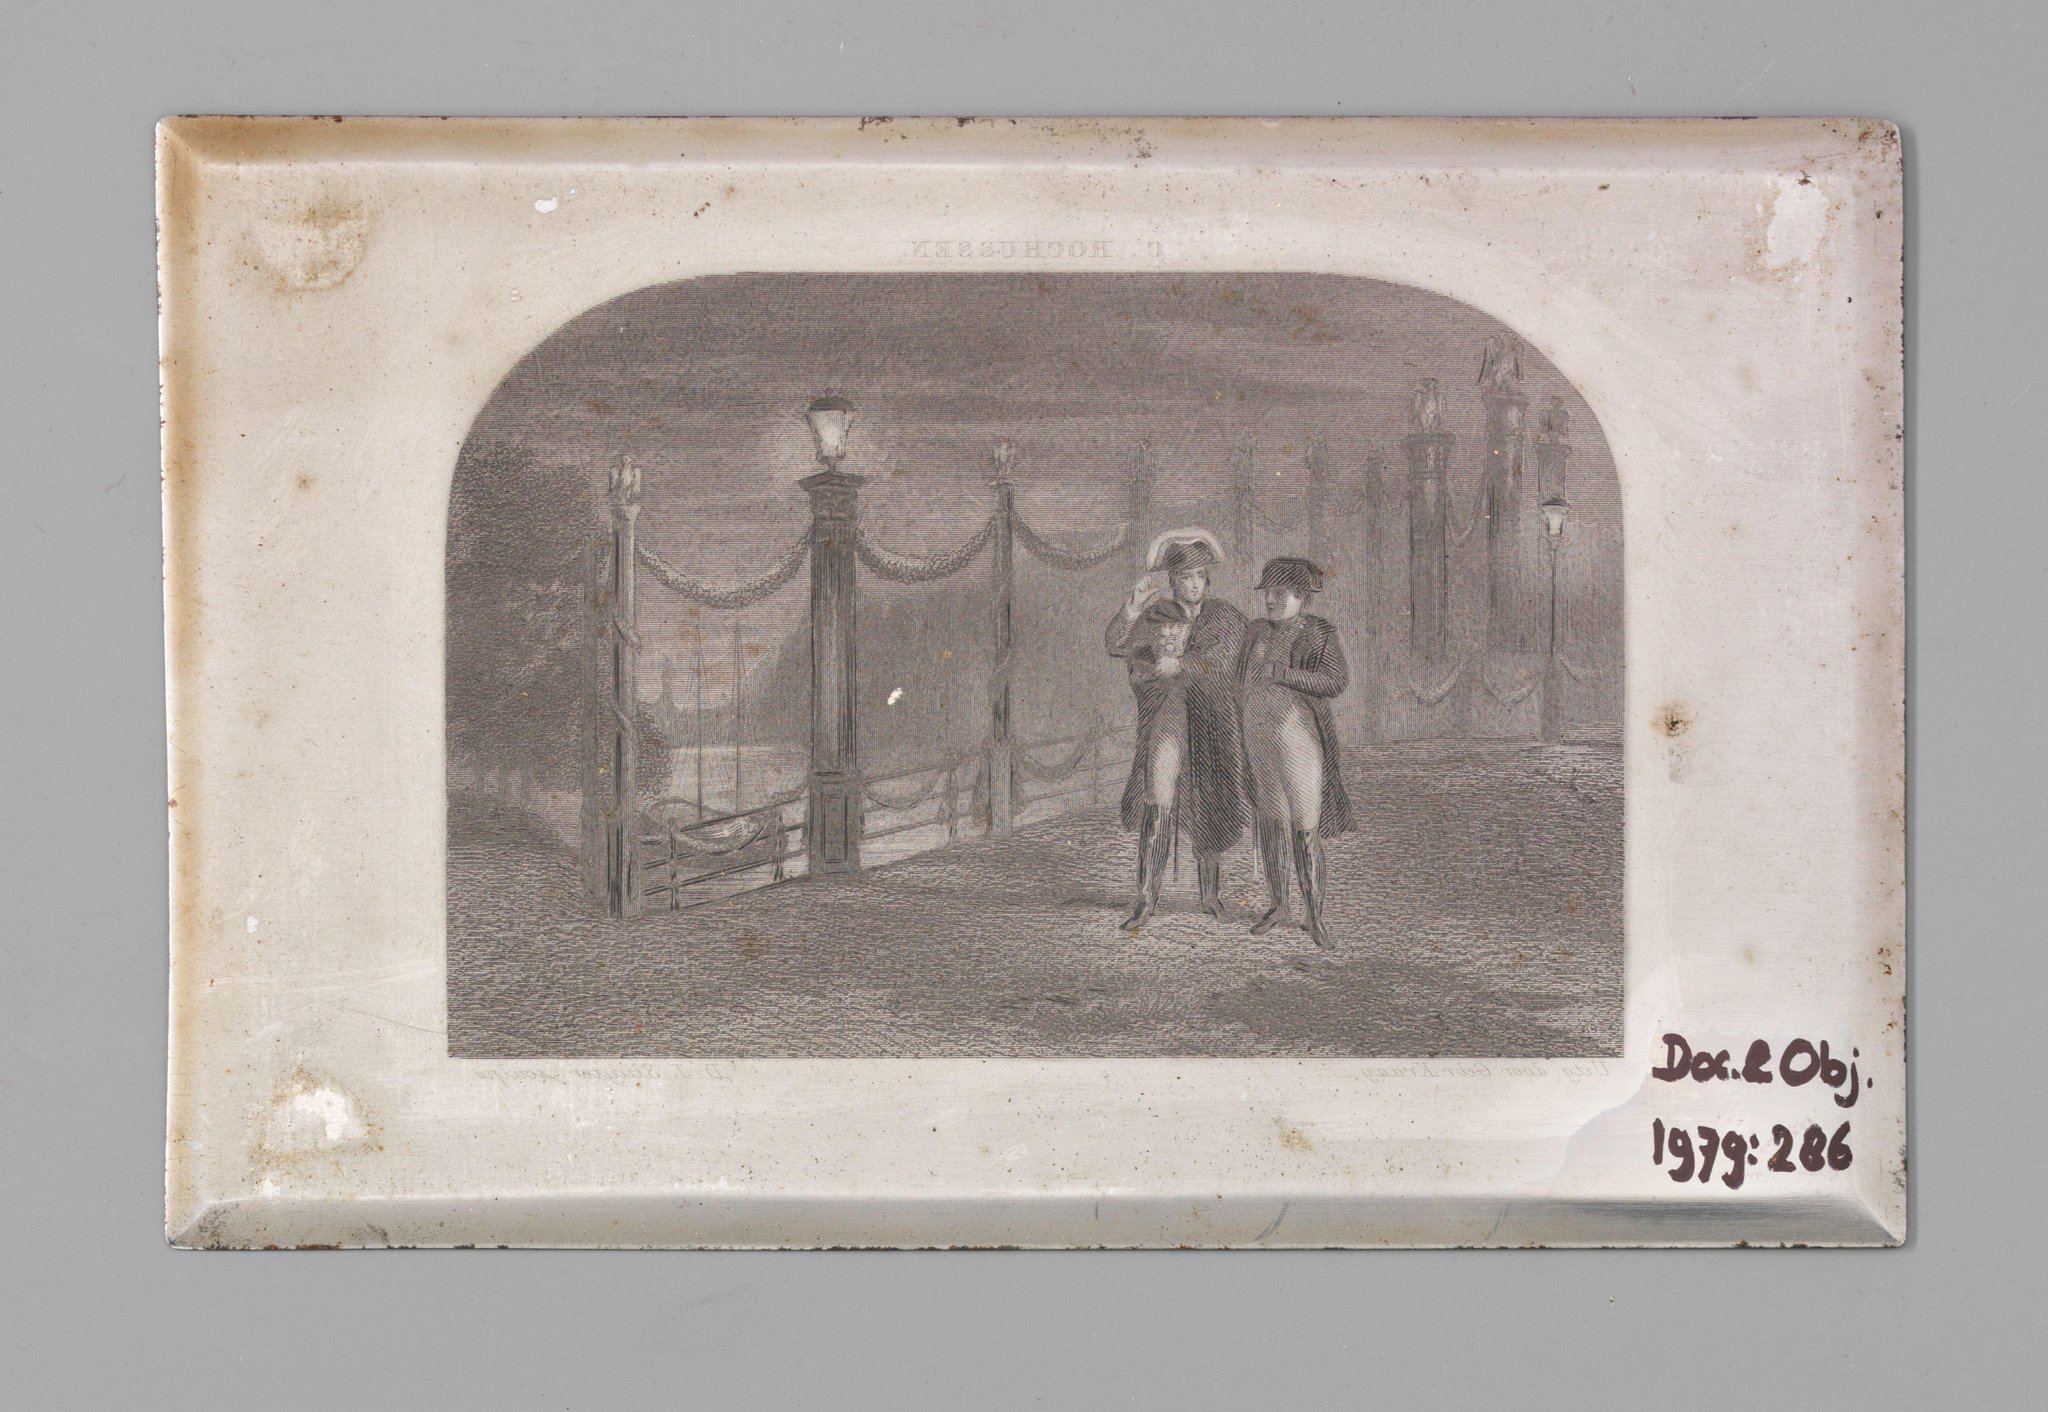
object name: staalplaat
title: Twee militairen in het donker op straat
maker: dirk jurriaan sluyter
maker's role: draughtsman, print maker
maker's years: 1811-1886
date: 1824-1870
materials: steel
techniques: engraving